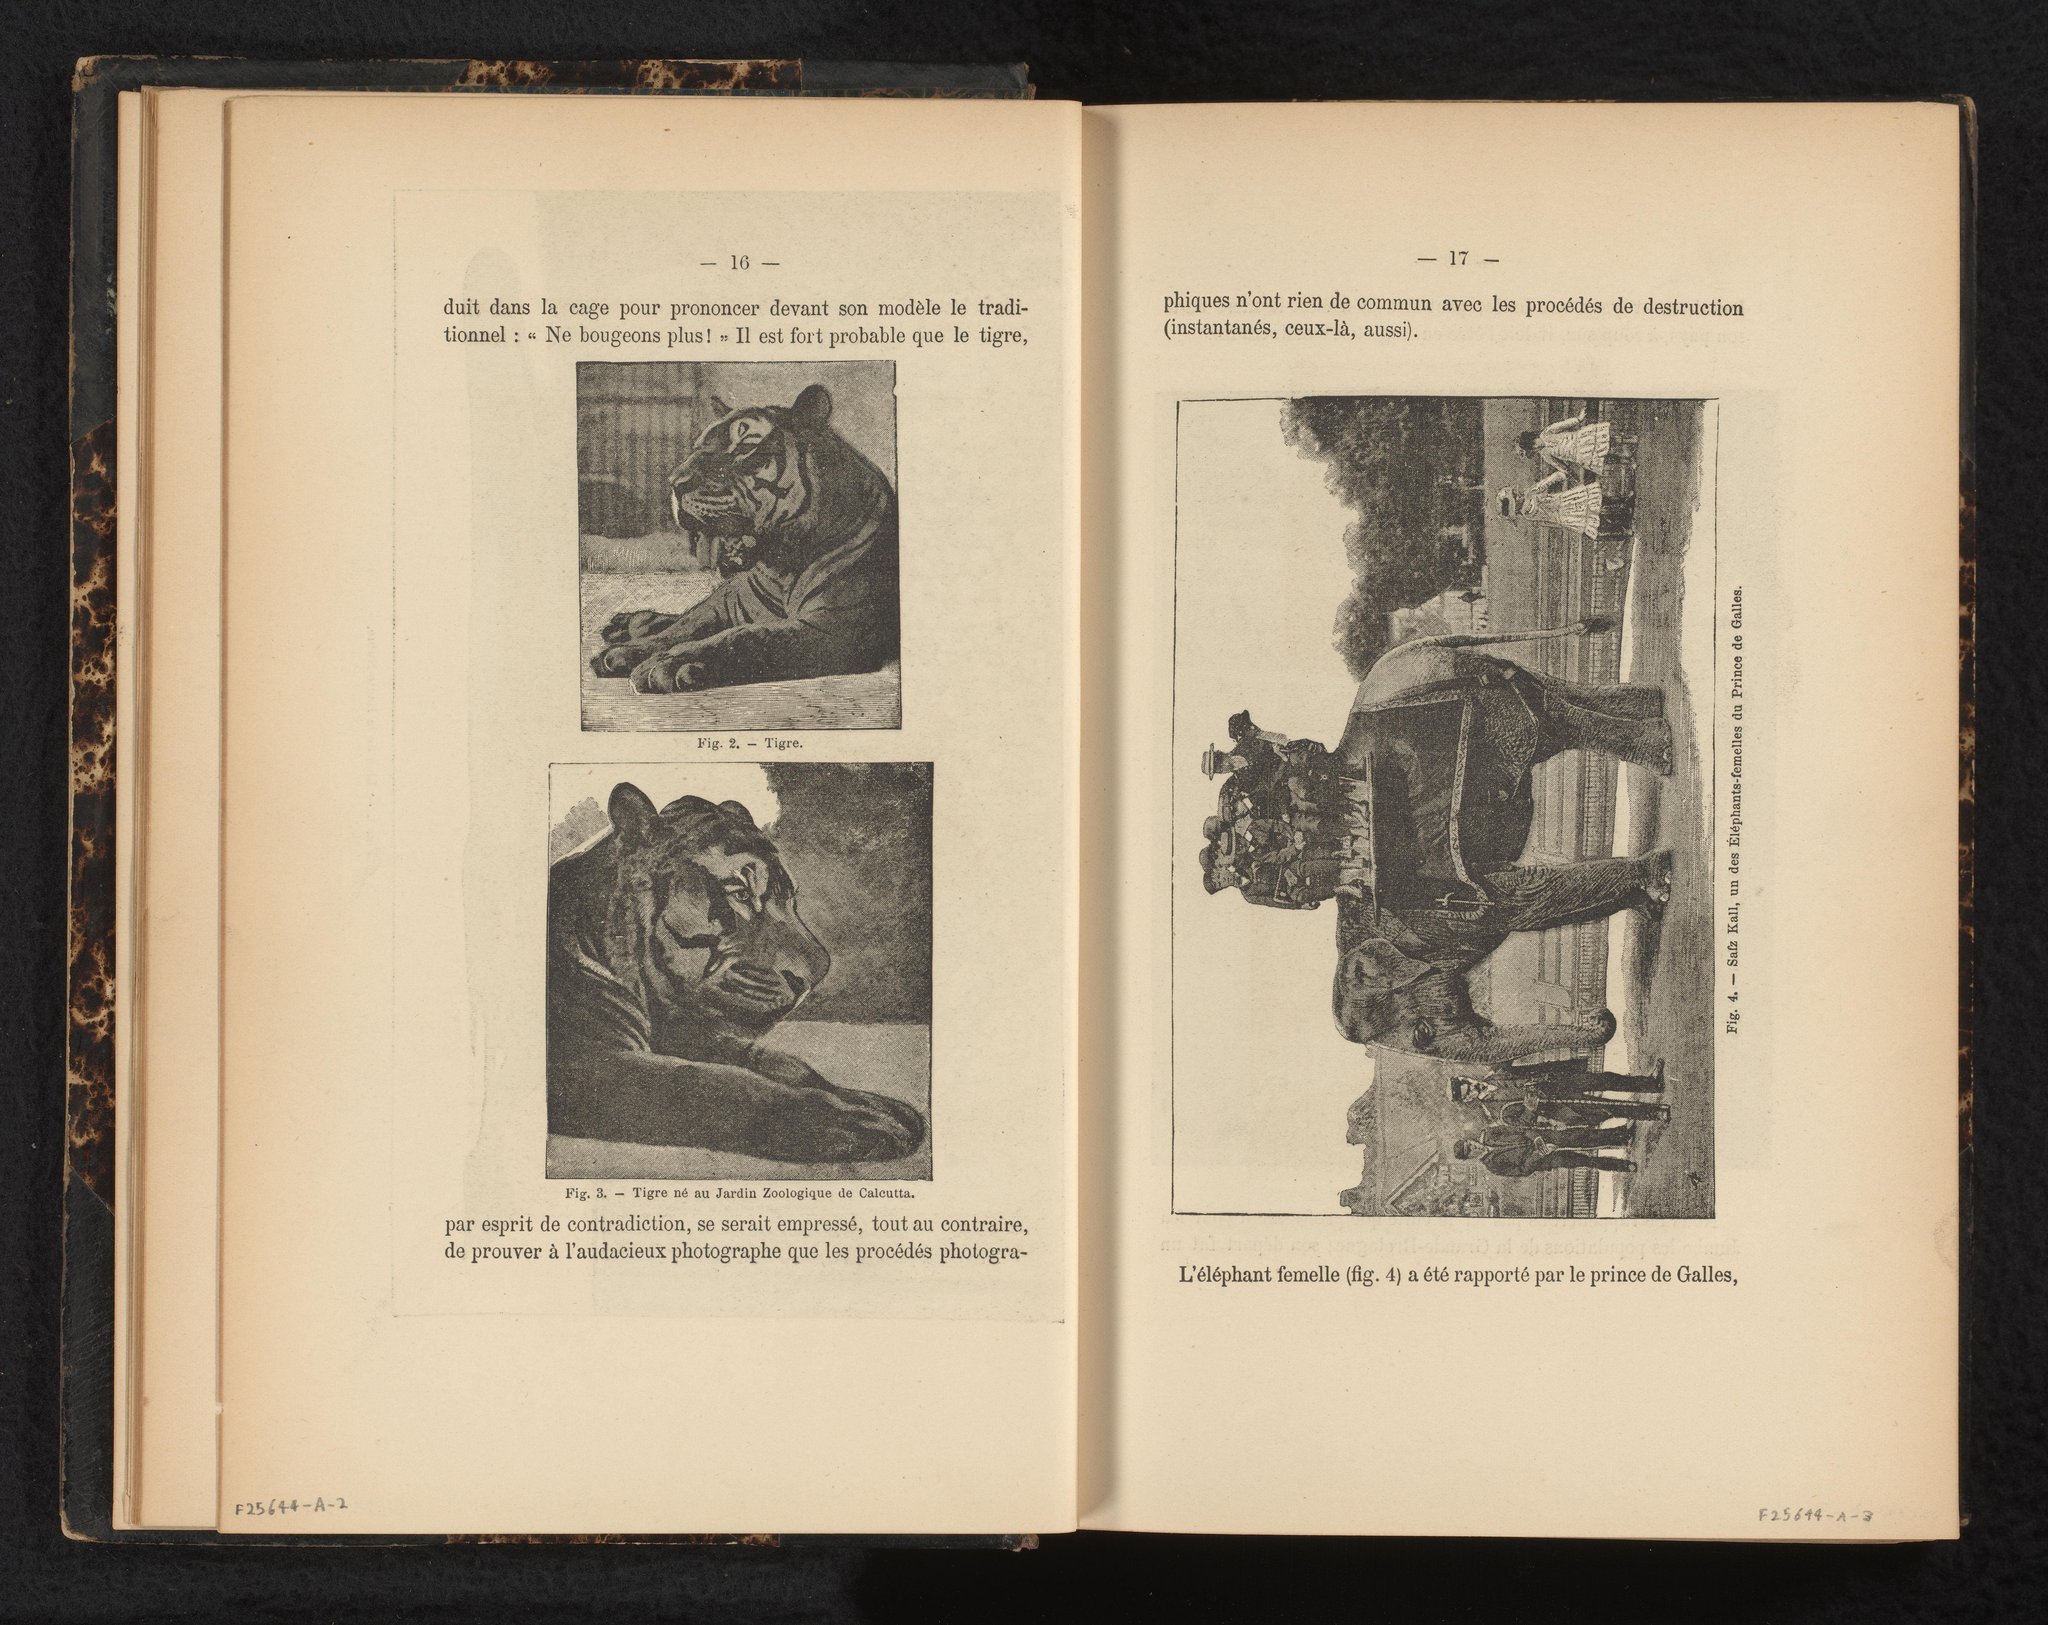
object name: photomechanical print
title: Tigre. Tigre né au Jardin Zoologique de Calcutta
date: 1882-1887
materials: paper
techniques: autotype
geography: london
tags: beasts of prey, predatory animals: tiger